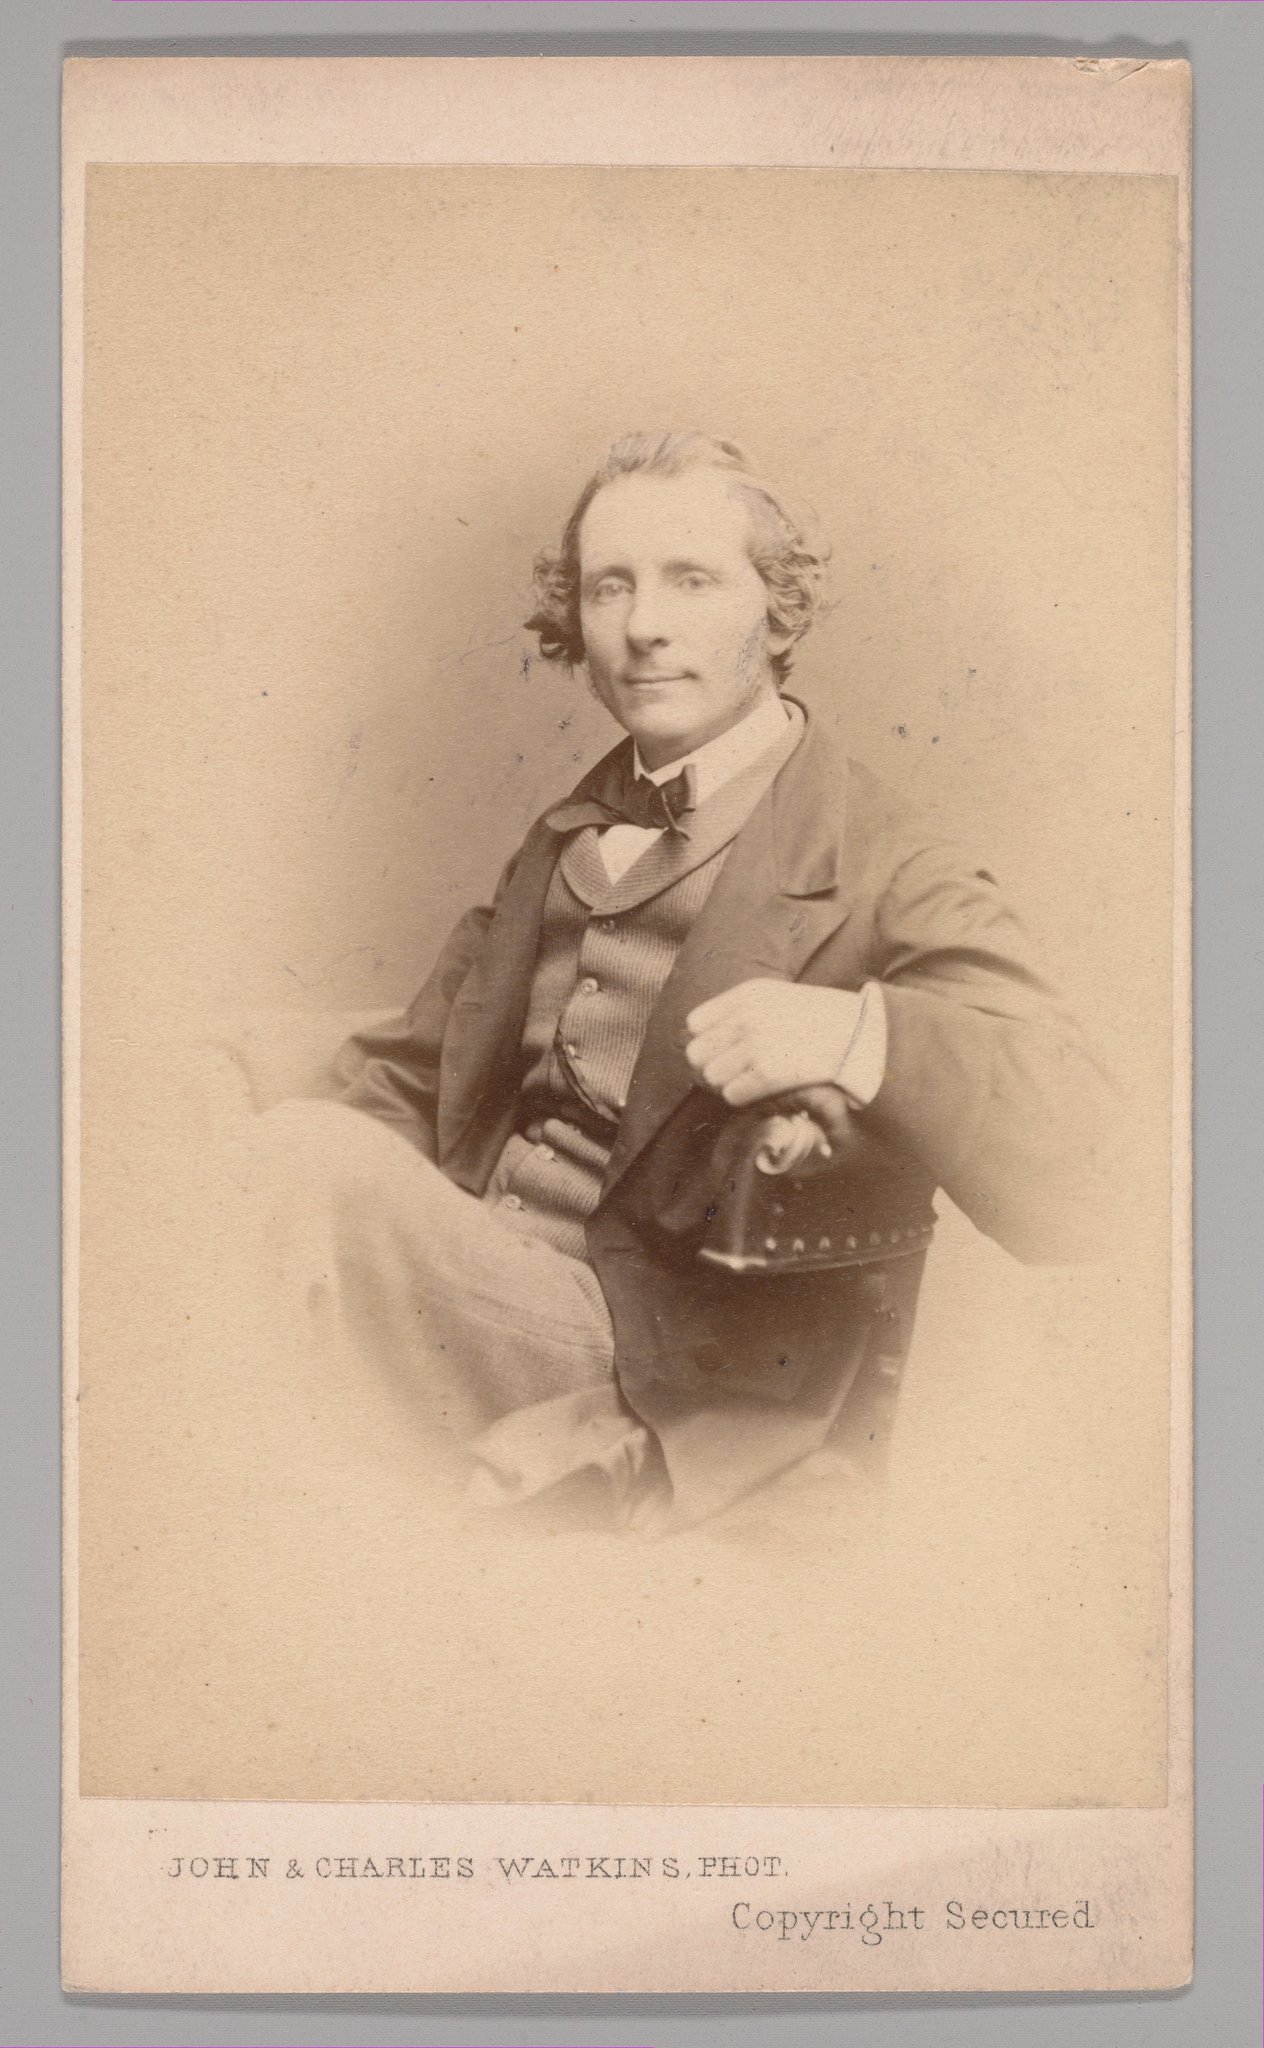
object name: carte de visite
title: [Frederick Goodall]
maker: john and charles watkins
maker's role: photography studio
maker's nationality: british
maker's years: 1840-1875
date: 1860-1869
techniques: albumen silver print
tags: men,portraits